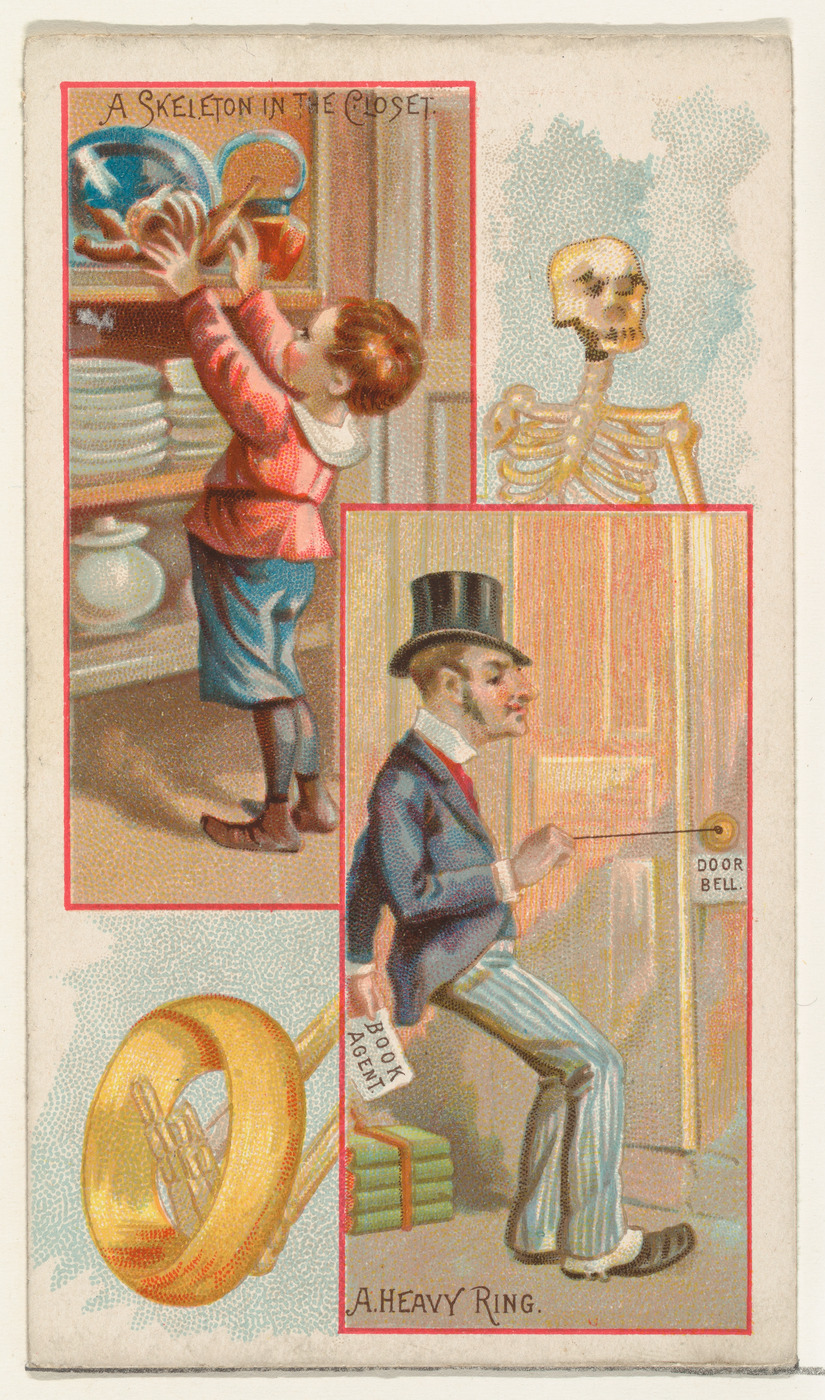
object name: print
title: A Skeleton in the Closet / A Heavy Ring, from the Jokes series (N118) issued by Duke Sons & Co. to promote Honest Long Cut Tobacco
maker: w. duke, sons & co.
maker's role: publisher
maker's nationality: american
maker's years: 1870-1920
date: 1891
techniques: color lithograph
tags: skeletons,boys,men